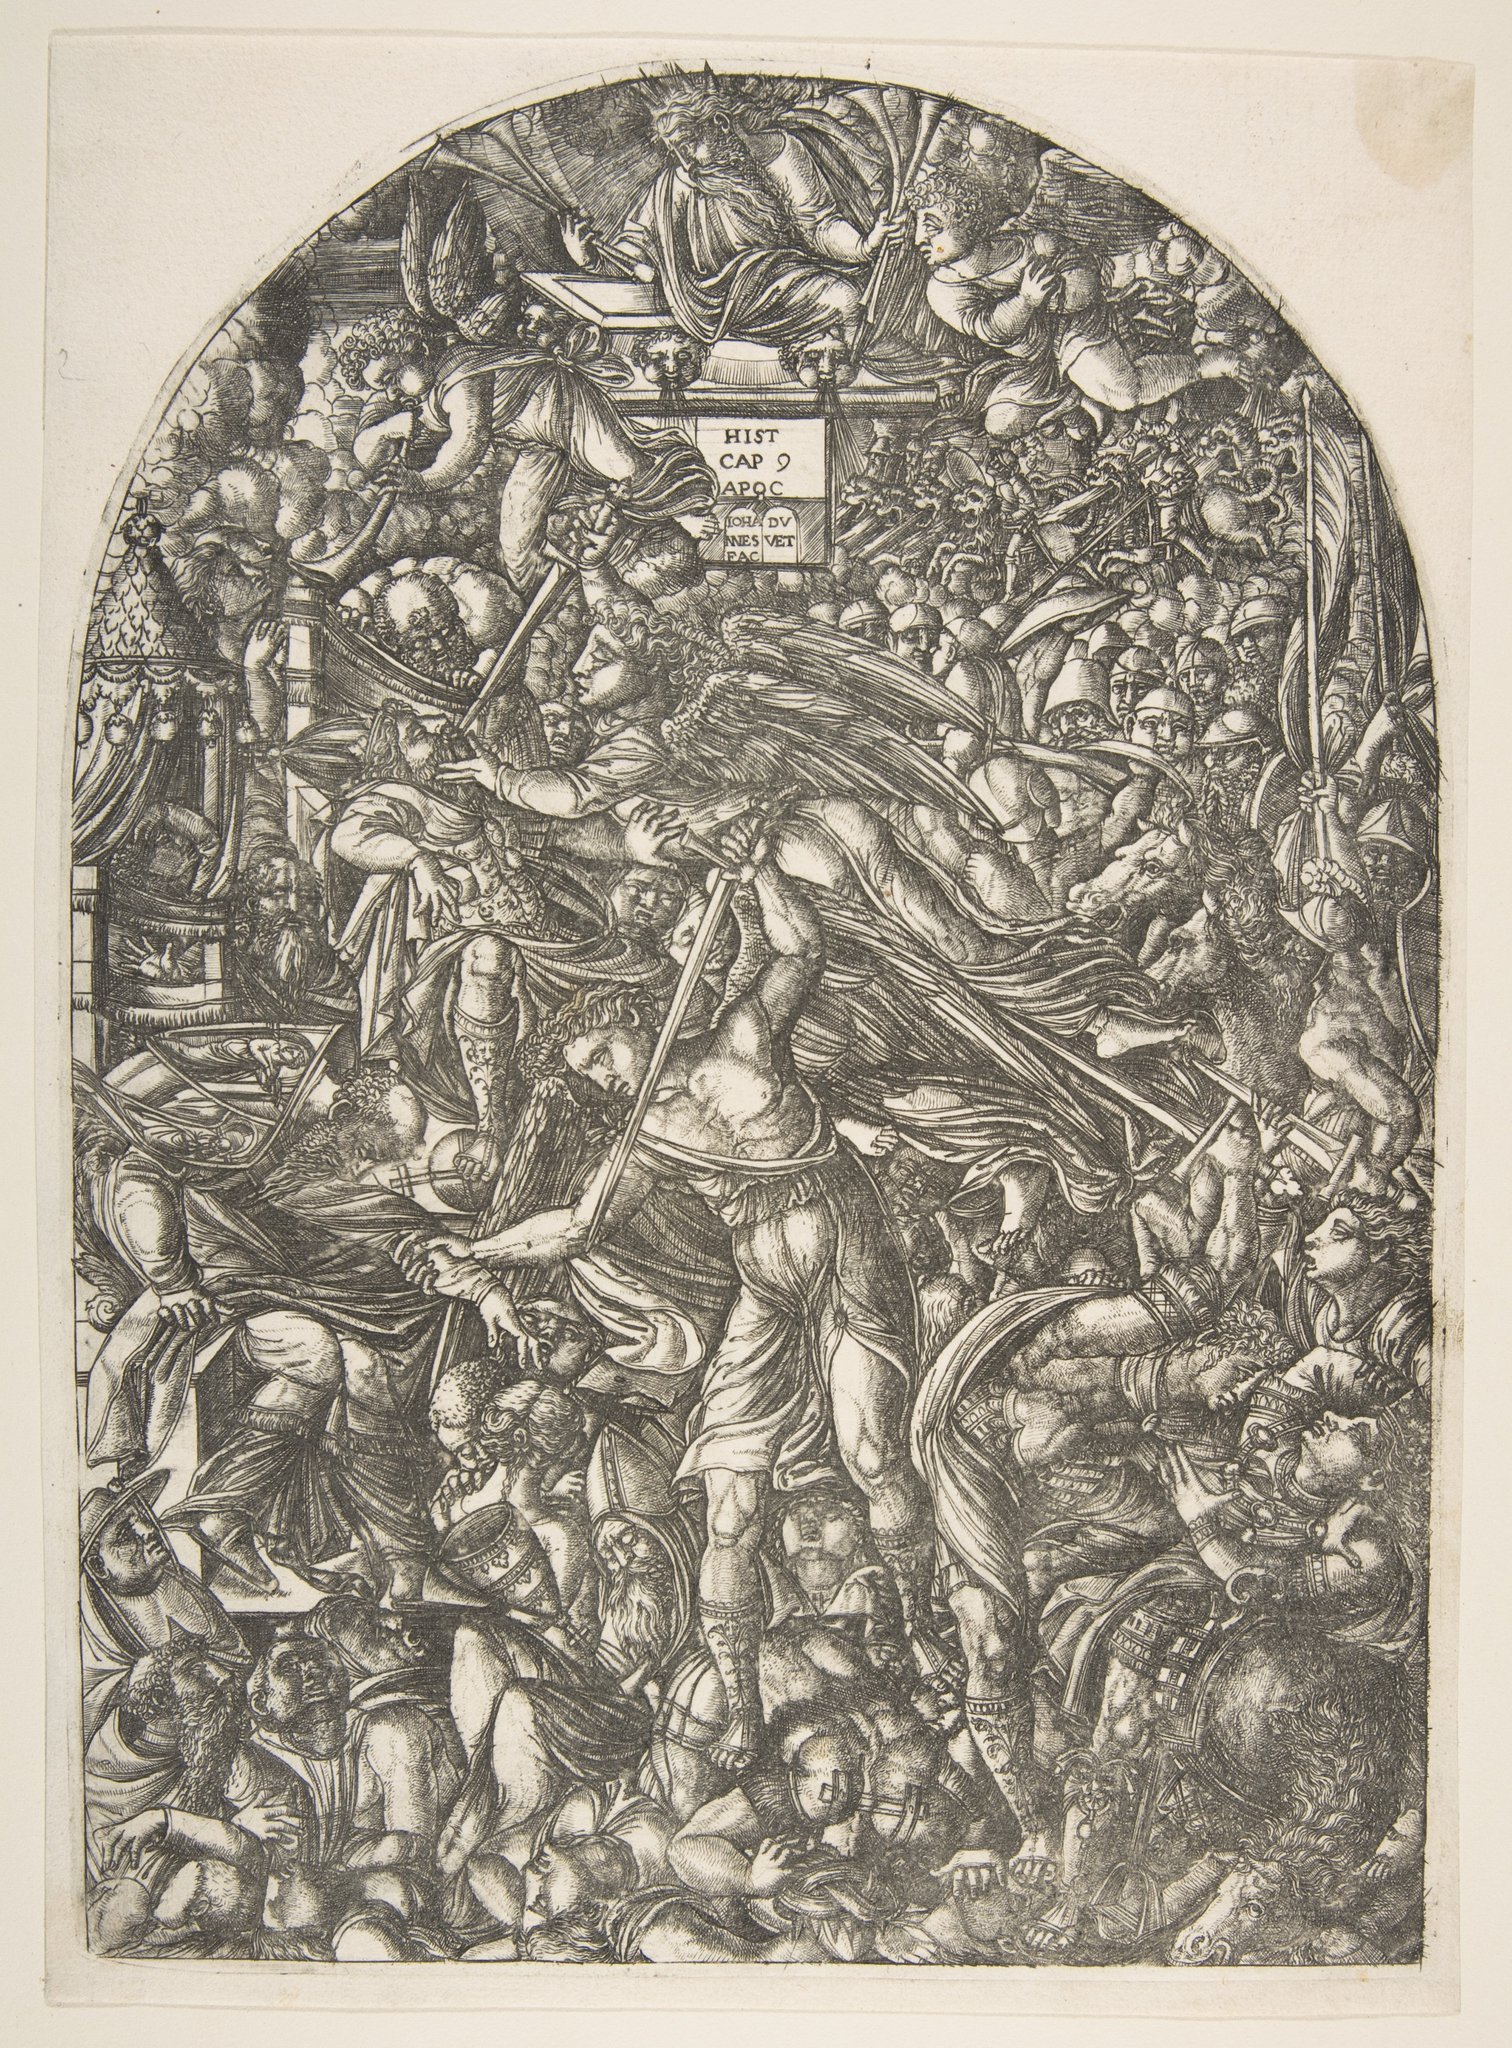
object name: print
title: The Angel sounding the Sixth Trumpet, from the Apocalypse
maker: jean duvet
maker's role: artist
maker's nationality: french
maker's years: 1485-1561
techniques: engraving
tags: swords,trumpets,angels,apocalypse